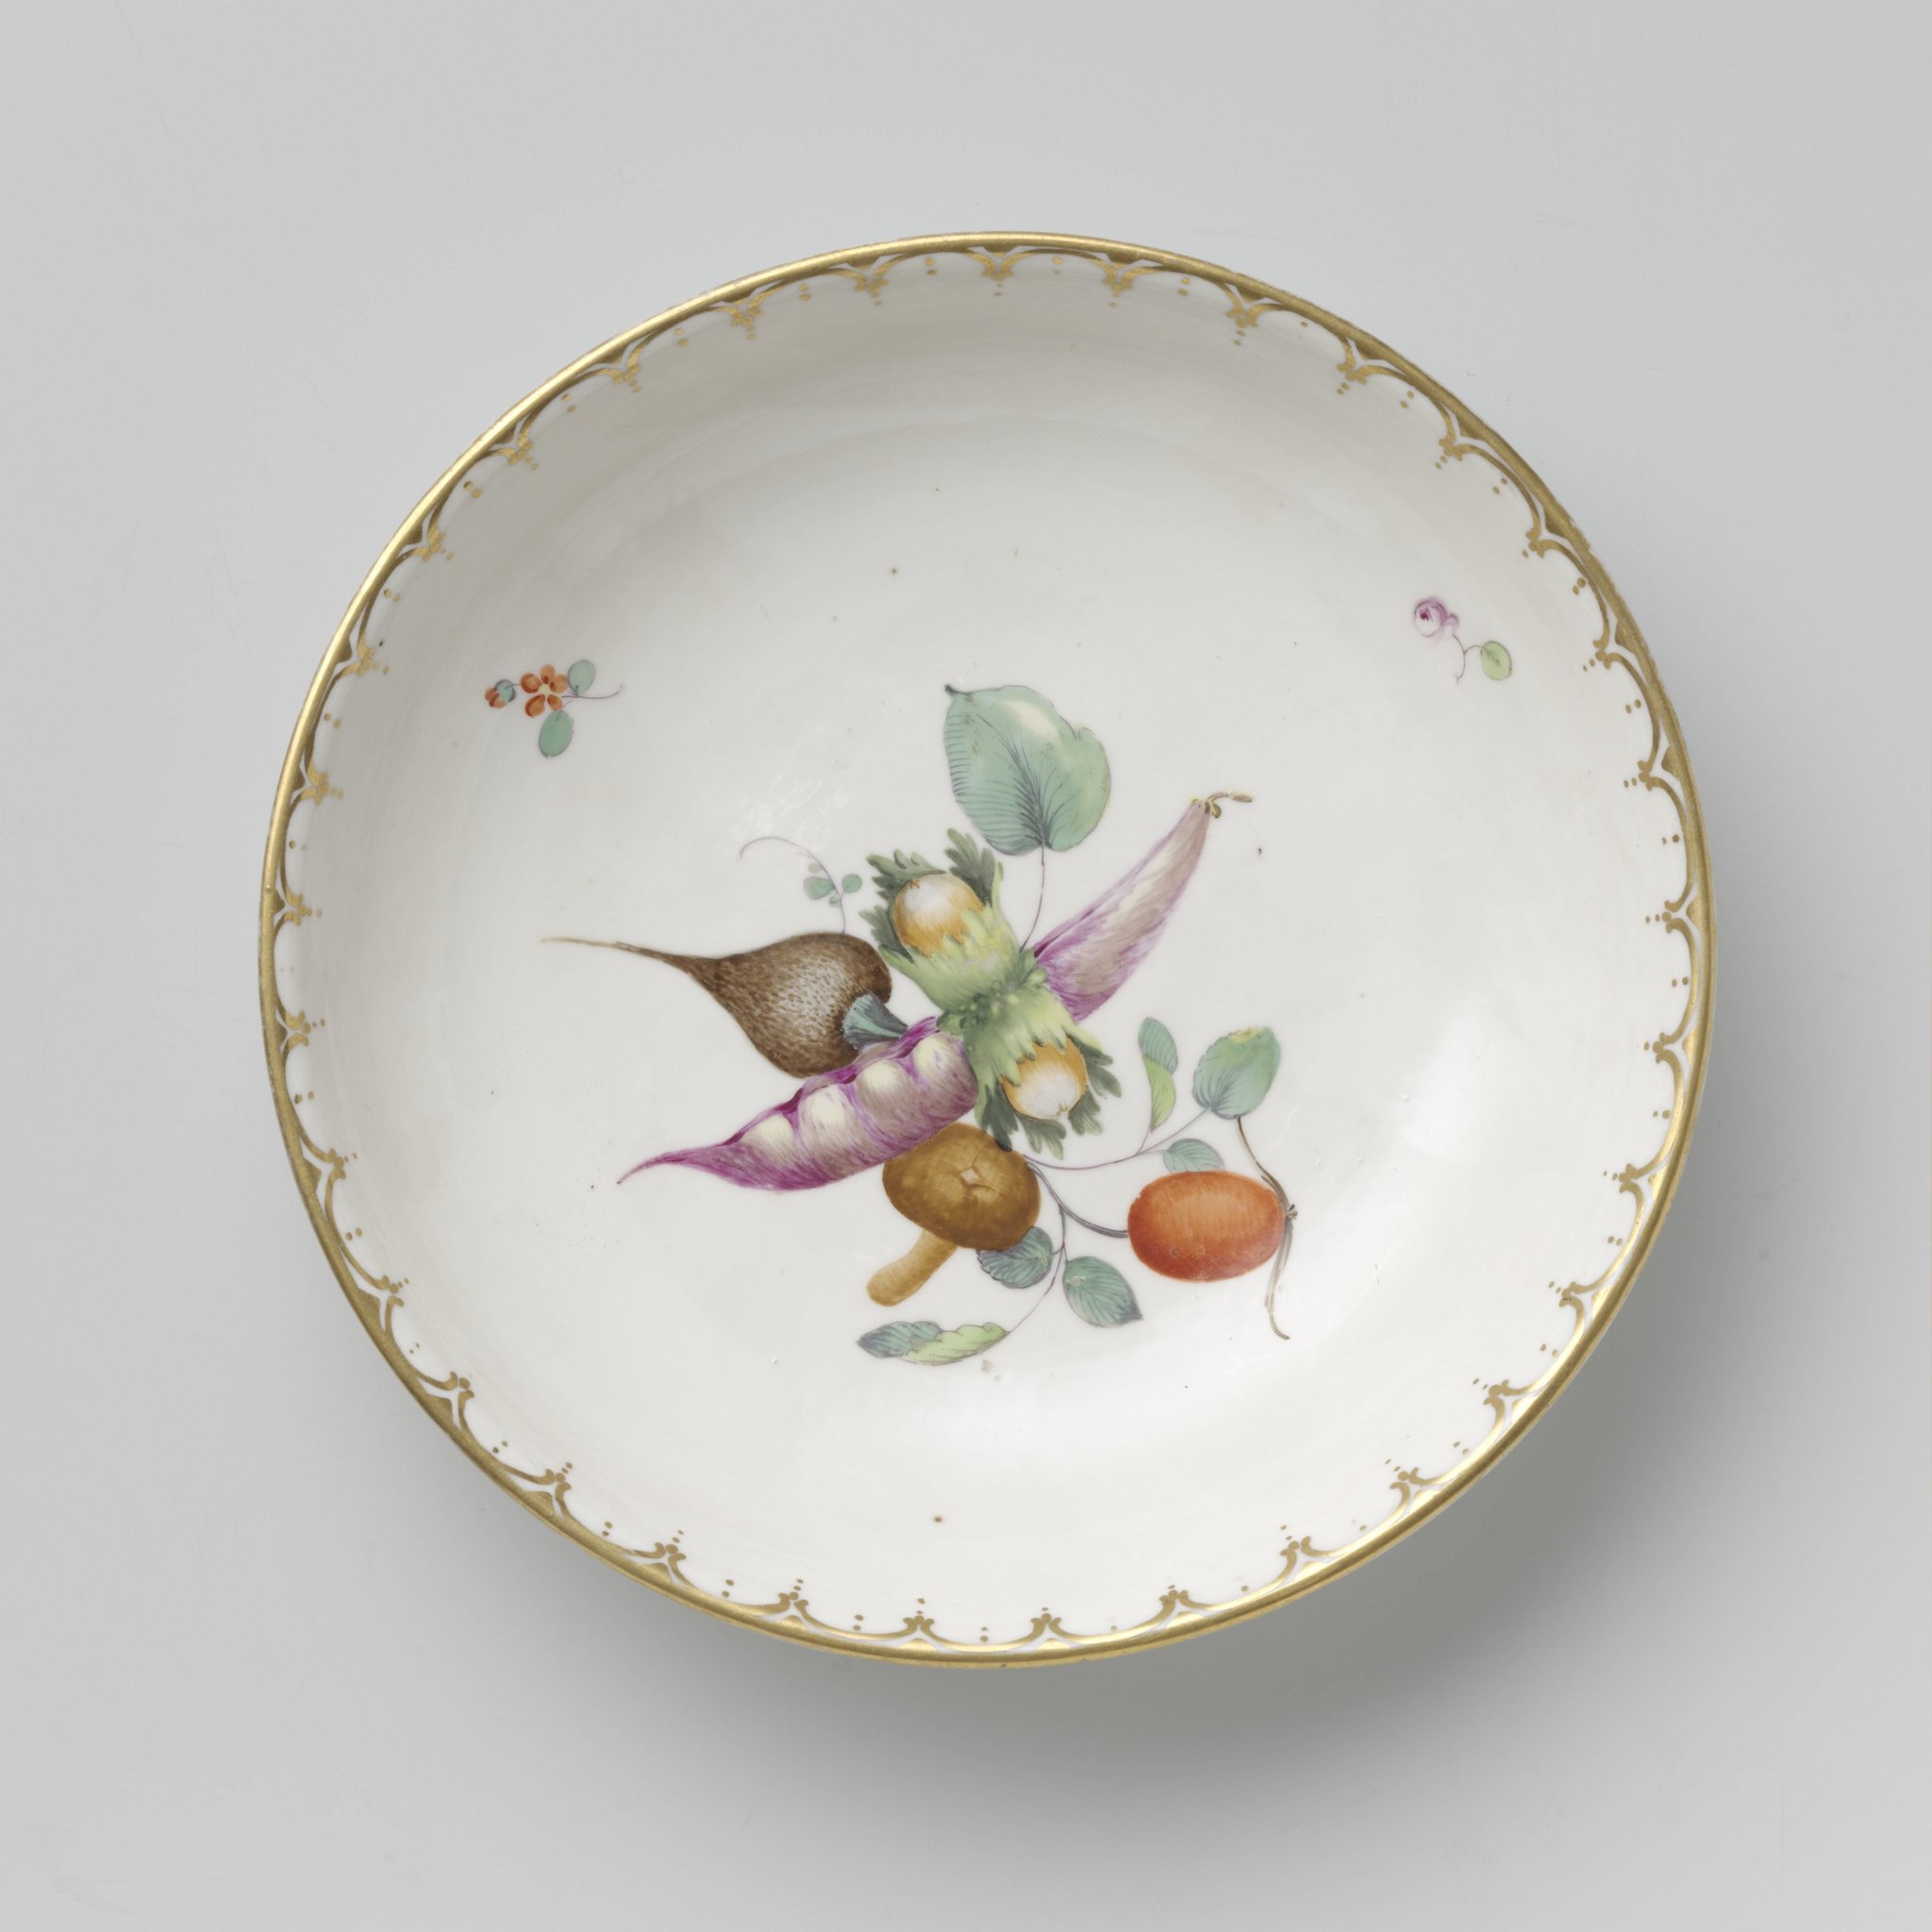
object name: platter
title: Schotel, beschilderd met groenten en vruchten omgeven door strooibloemen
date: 1777-1790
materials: porcelain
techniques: painted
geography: the hague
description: Schotel, veelkleurig beschilderd met een decor van groenten en vruchten omgeven door strooibloempjes. Gemerkt met een ooievaar in blauw onder de glazuur. N.B. Duits porselein beschilderd in Den Haag.